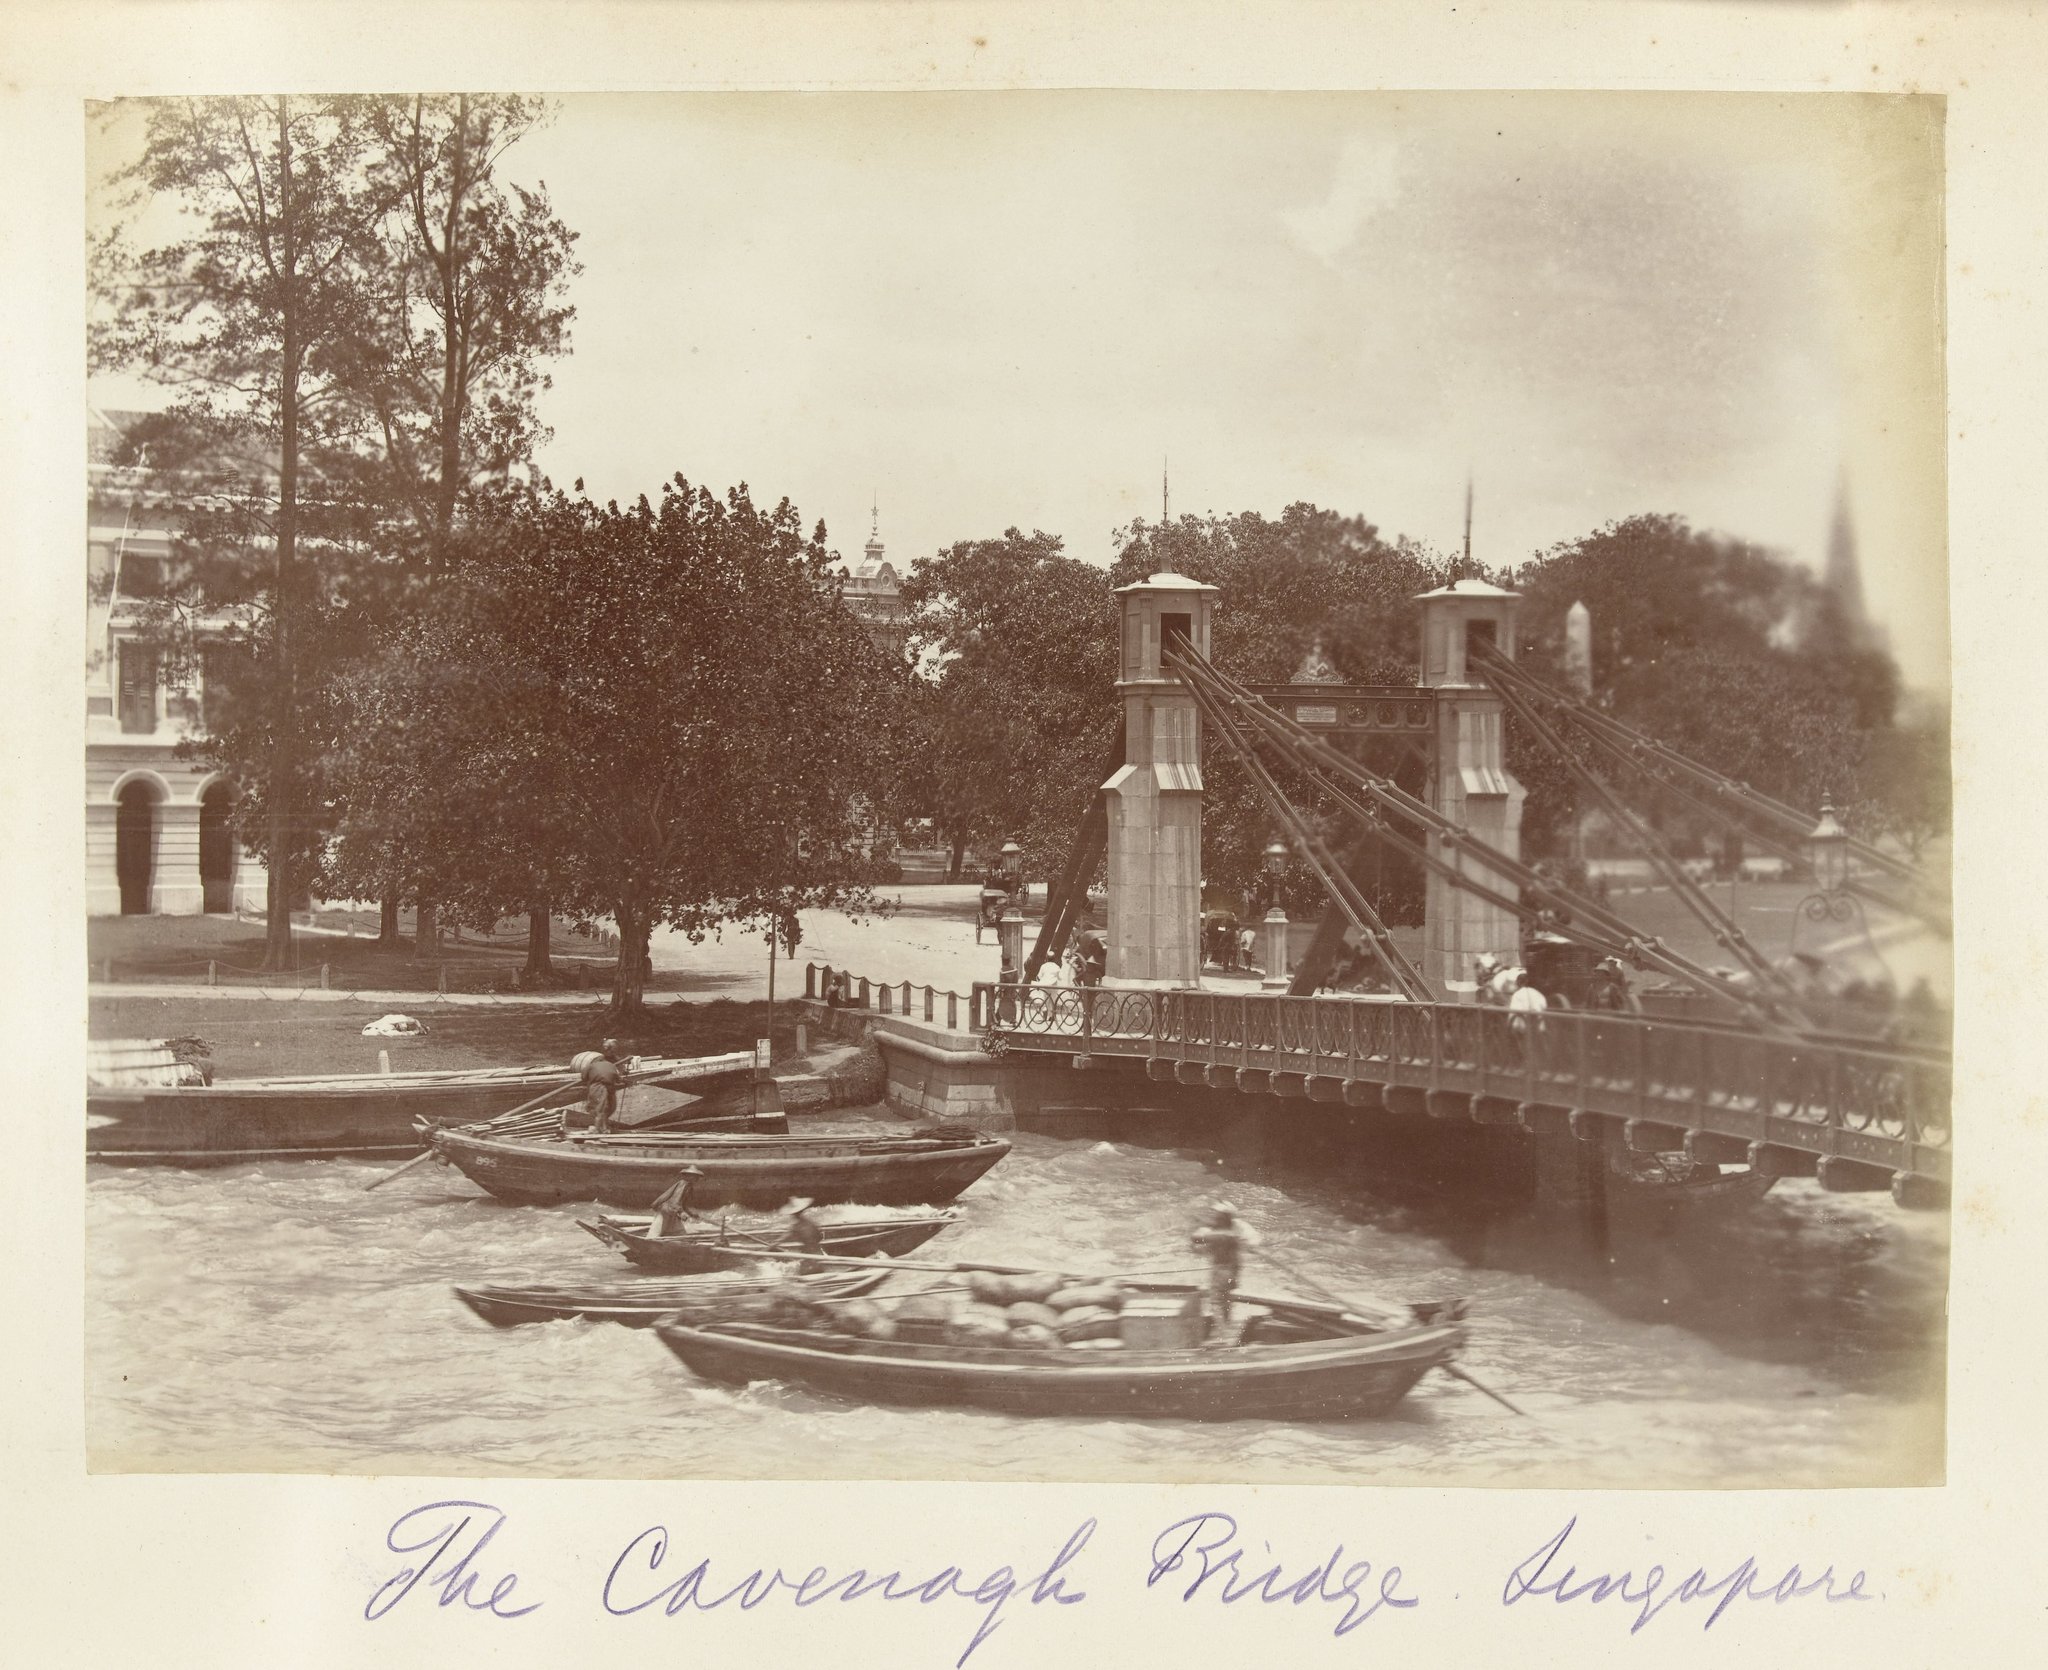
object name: photograph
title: Cavenagh brug over de Singapore rivier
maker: Anonymous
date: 1890-1910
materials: cardboard, paper, photographic support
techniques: gelatin silver print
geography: netherlands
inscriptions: caption: ‘The Cavenagh Bridge, Singapore’